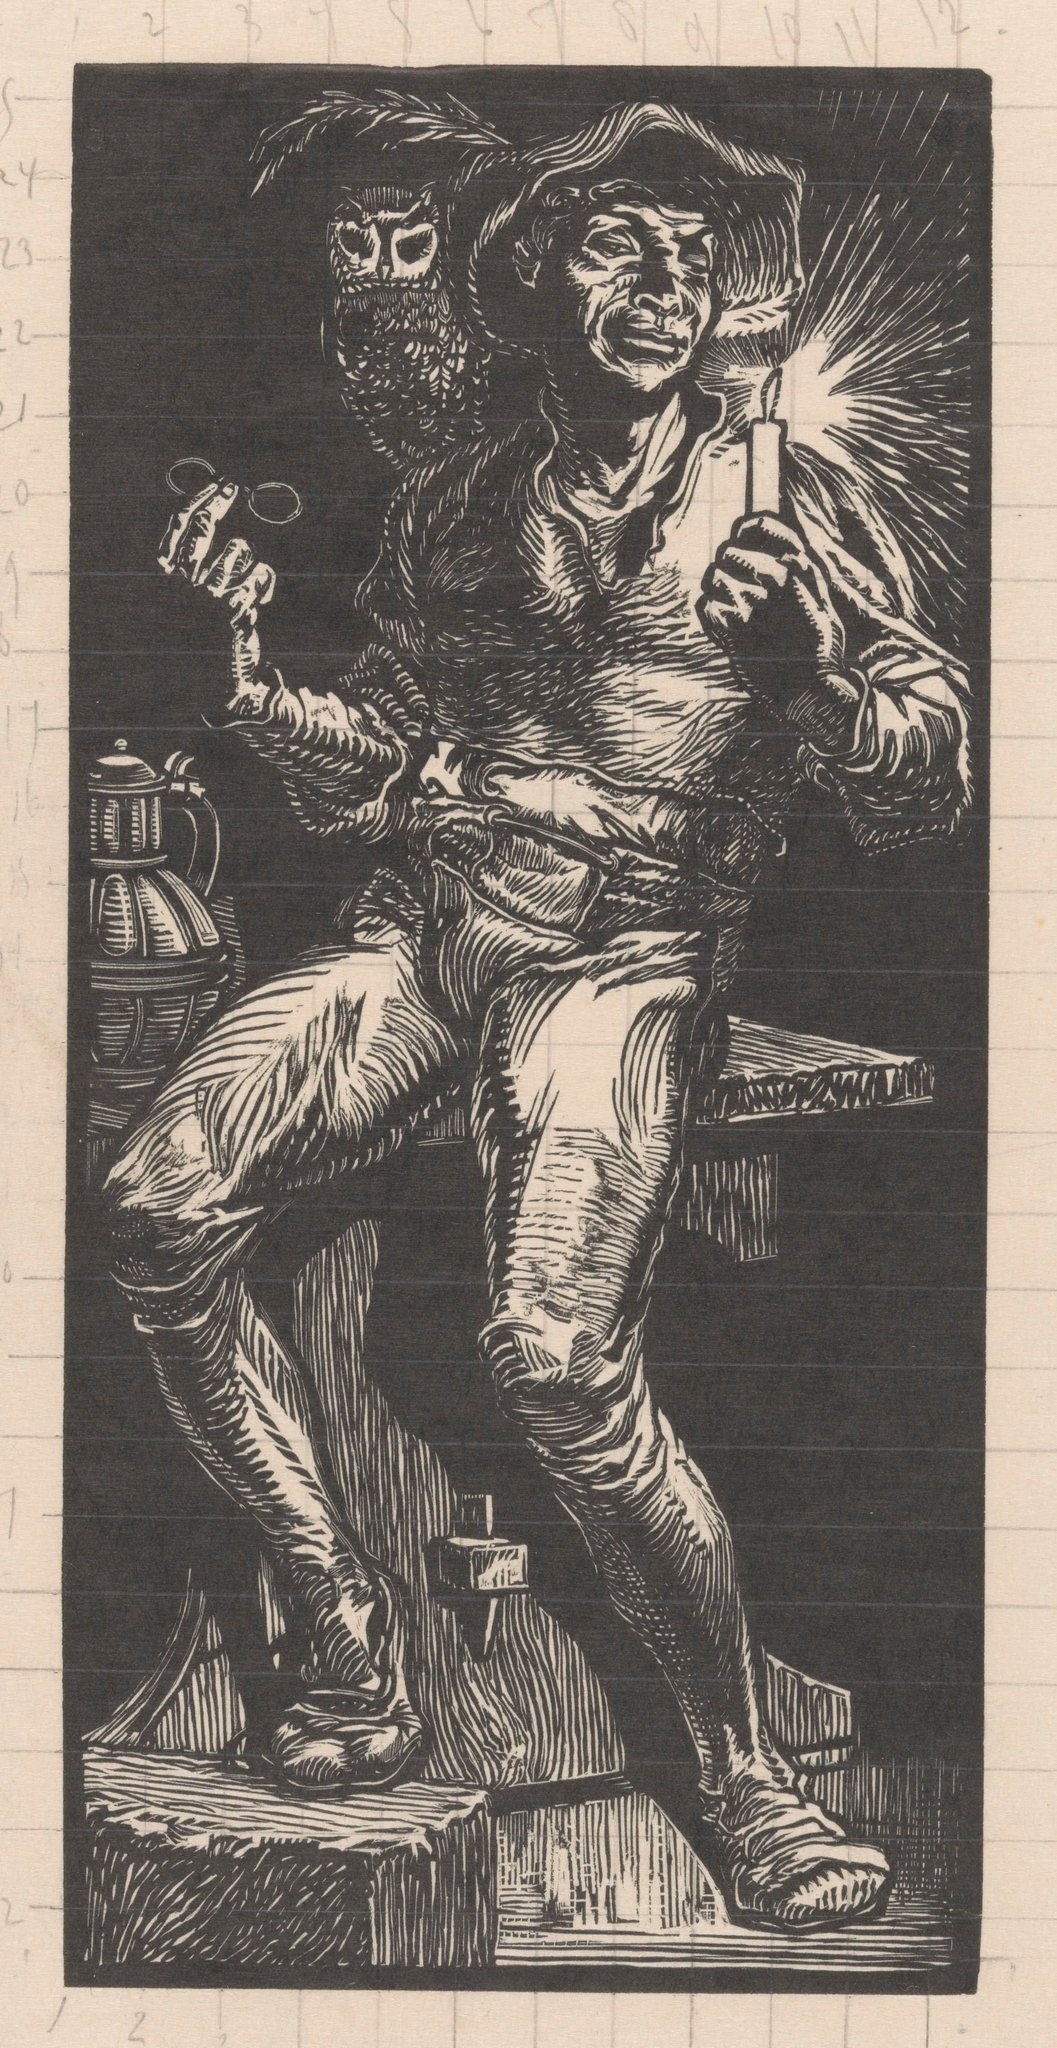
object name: print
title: Tijl Uilenspiegel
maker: johannes josephus aarts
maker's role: draughtsman, print maker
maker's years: 1871-1934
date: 1881-1934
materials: paper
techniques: drawing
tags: eyeglasses, spectacles, eulenspiegel, candle, owls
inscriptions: collector's mark: Lugt 2165, collector's mark: Lugt 2760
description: Tijl Uilenspiegel, leunend tegen een tafel. In zijn rechterhand een bril, in zijn linkerhand een kaars. Op zijn rechterschouder een uil.